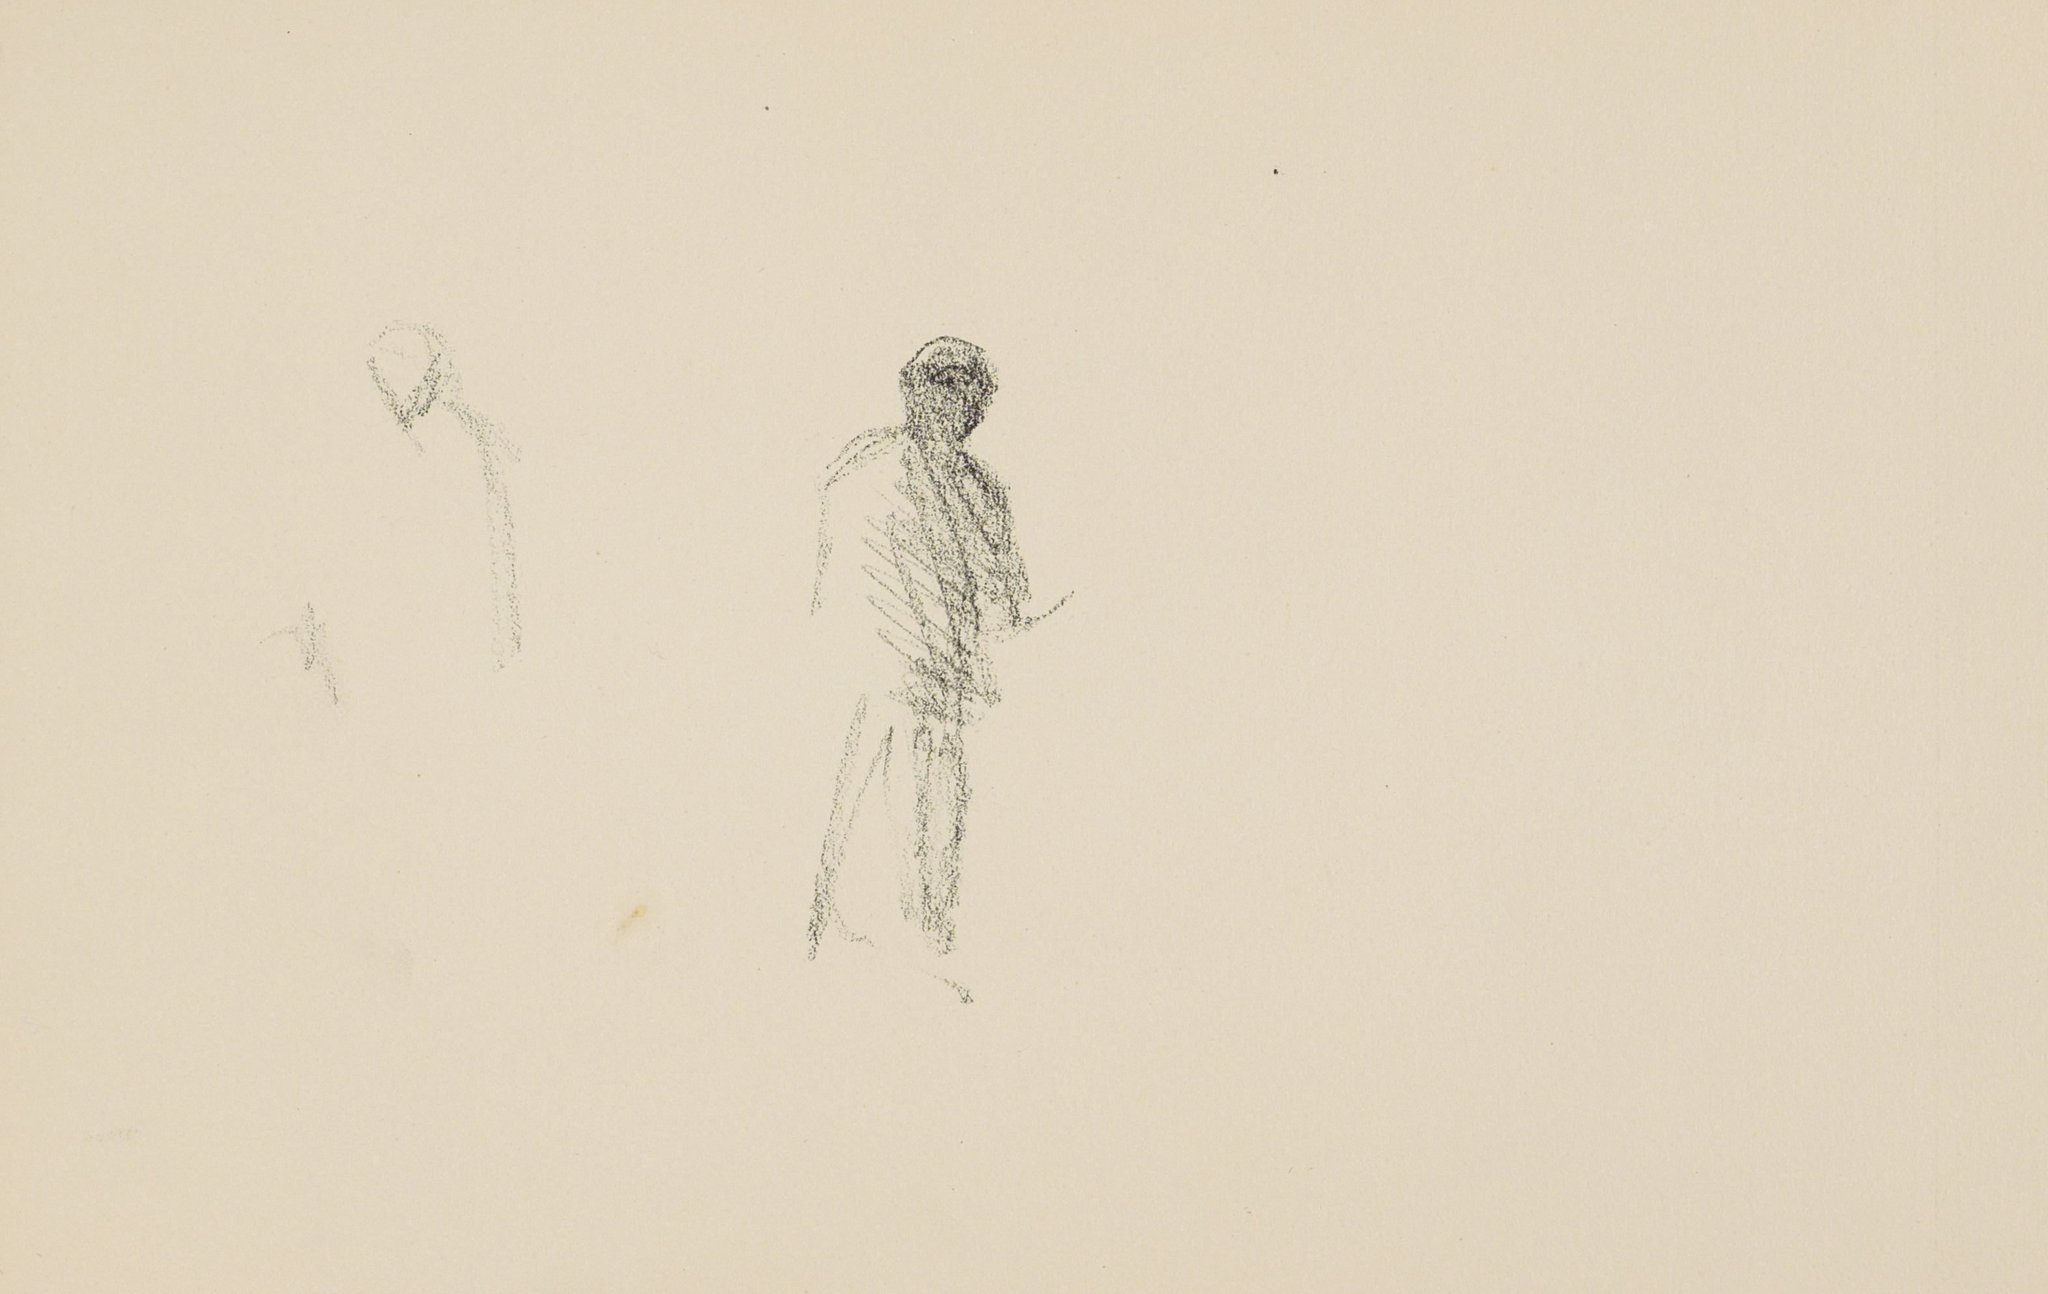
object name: sketchbook leaf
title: Staande man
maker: a.a.l. de grammont-hubrecht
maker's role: draughtsman, painter, print maker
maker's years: 1855-1913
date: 1865-1913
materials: chalk, paper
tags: standing figure, adult man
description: Blad 63 recto uit een schetsboek met 65 bladen.